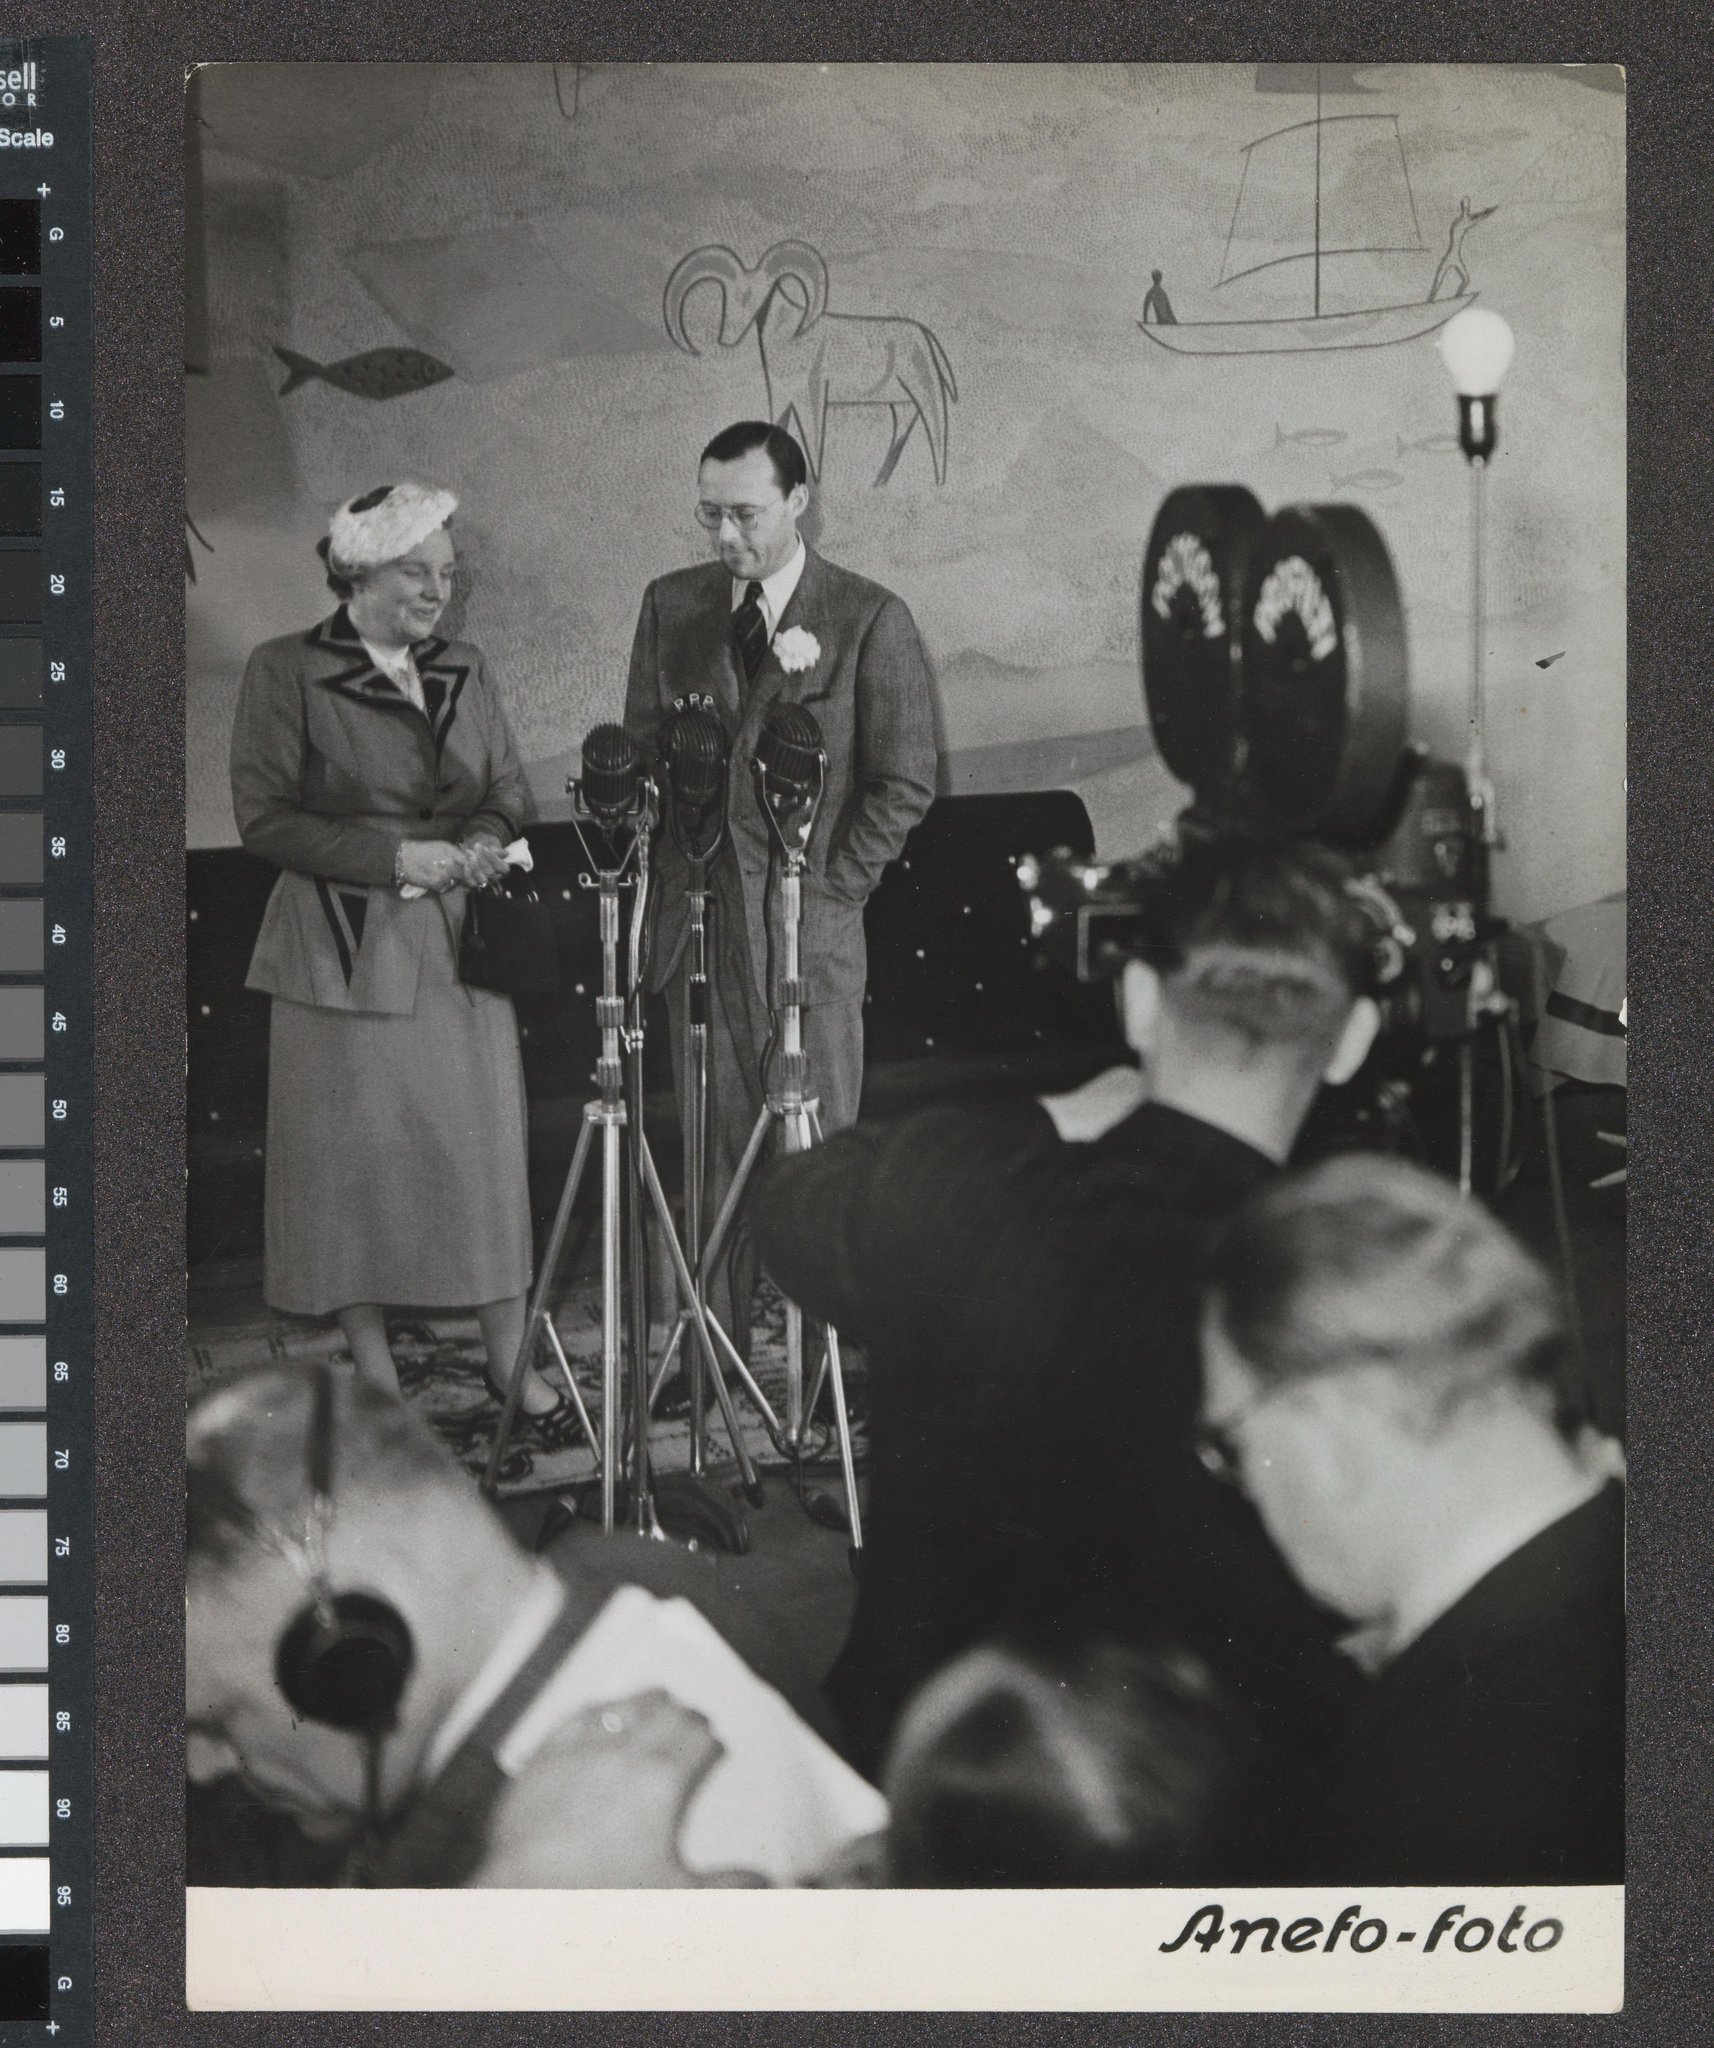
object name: photograph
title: H.M. en Pr. Bernh. poseren voor TV voor hun vertrek naar Amerika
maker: Anonymous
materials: photographic support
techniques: gelatin silver print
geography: netherlands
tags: utrecht, bernhard (prins der nederlanden), juliana of the netherlands, press, journalism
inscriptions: signature: ‘copyright ANEFO Achtergracht 17 Amsterdam-C no 50307’